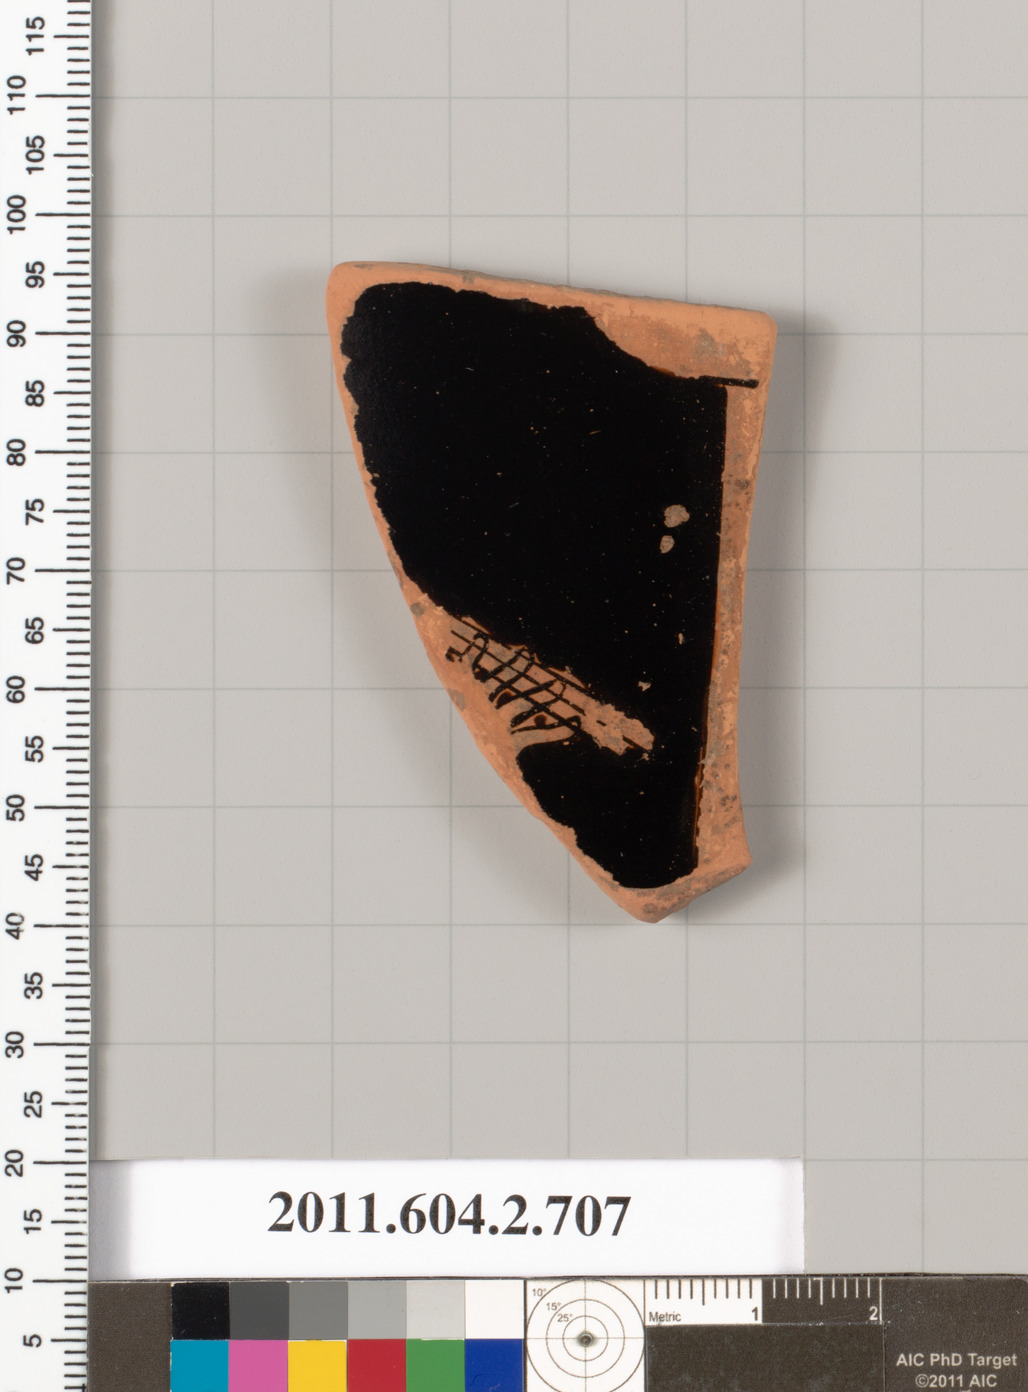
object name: calyx krater fragment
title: Terracotta fragment of a calyx-krater (bowl for mixing wine and water)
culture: greek, attic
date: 490-480 BCE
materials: terracotta